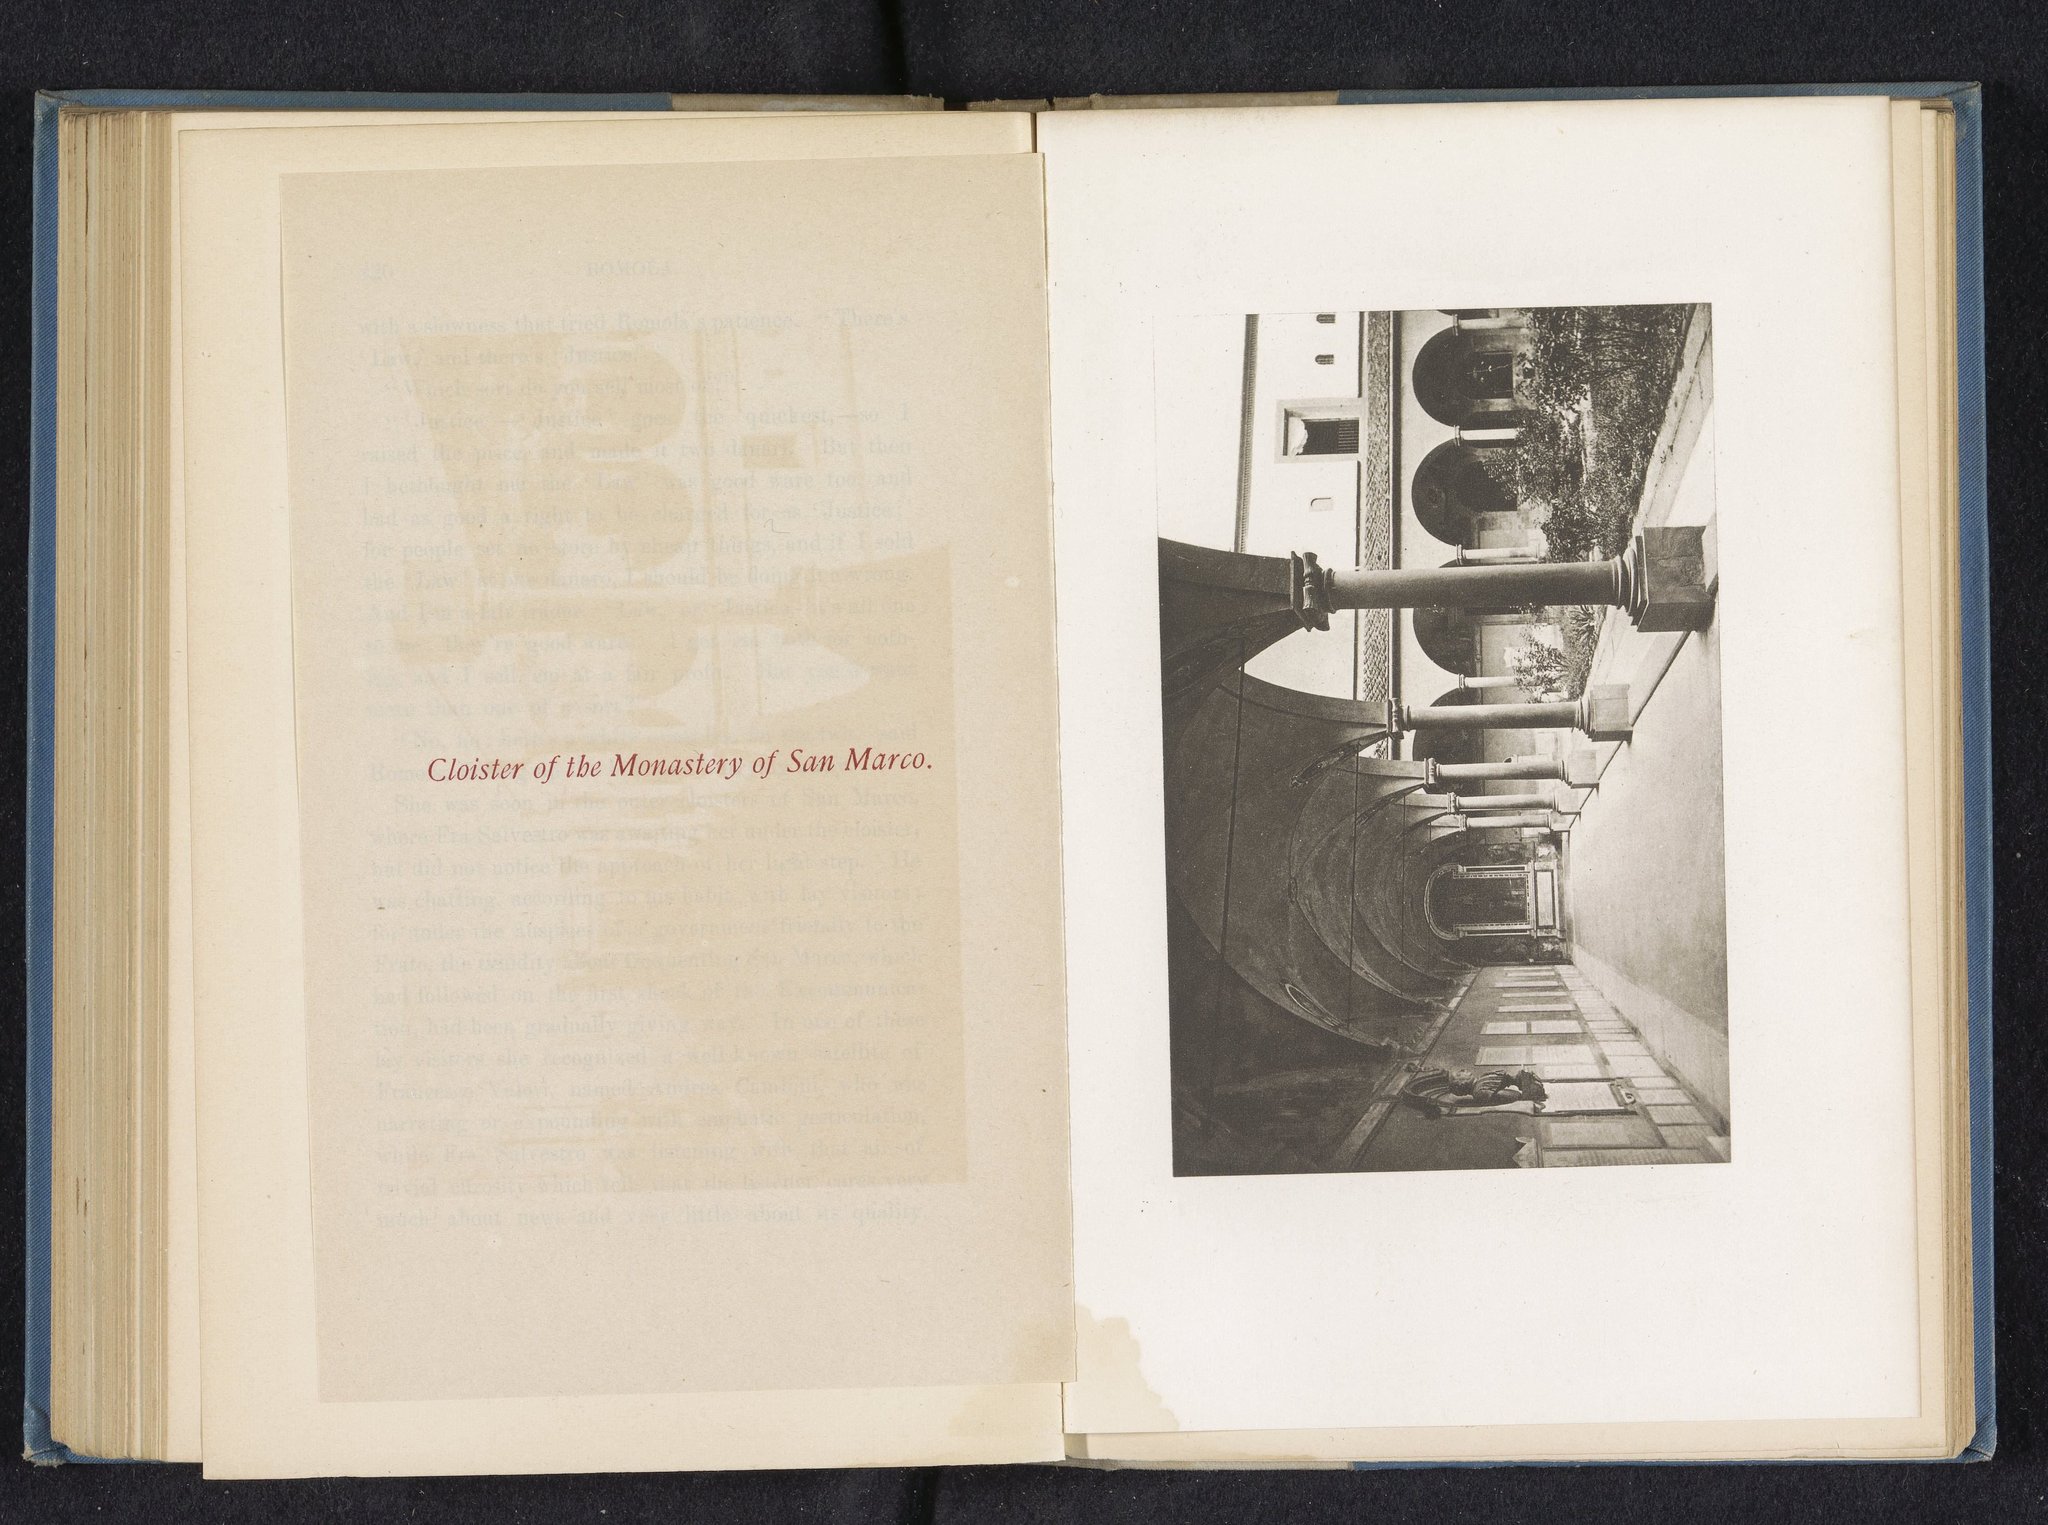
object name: page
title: Kloostergang van het San Marco-klooster te Florence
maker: Anonymous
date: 1880-1890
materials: paper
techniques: photoaquatint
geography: boston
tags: cloisters ~ monastery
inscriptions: title: ‘Cloister of the Monastery of San Marco.’